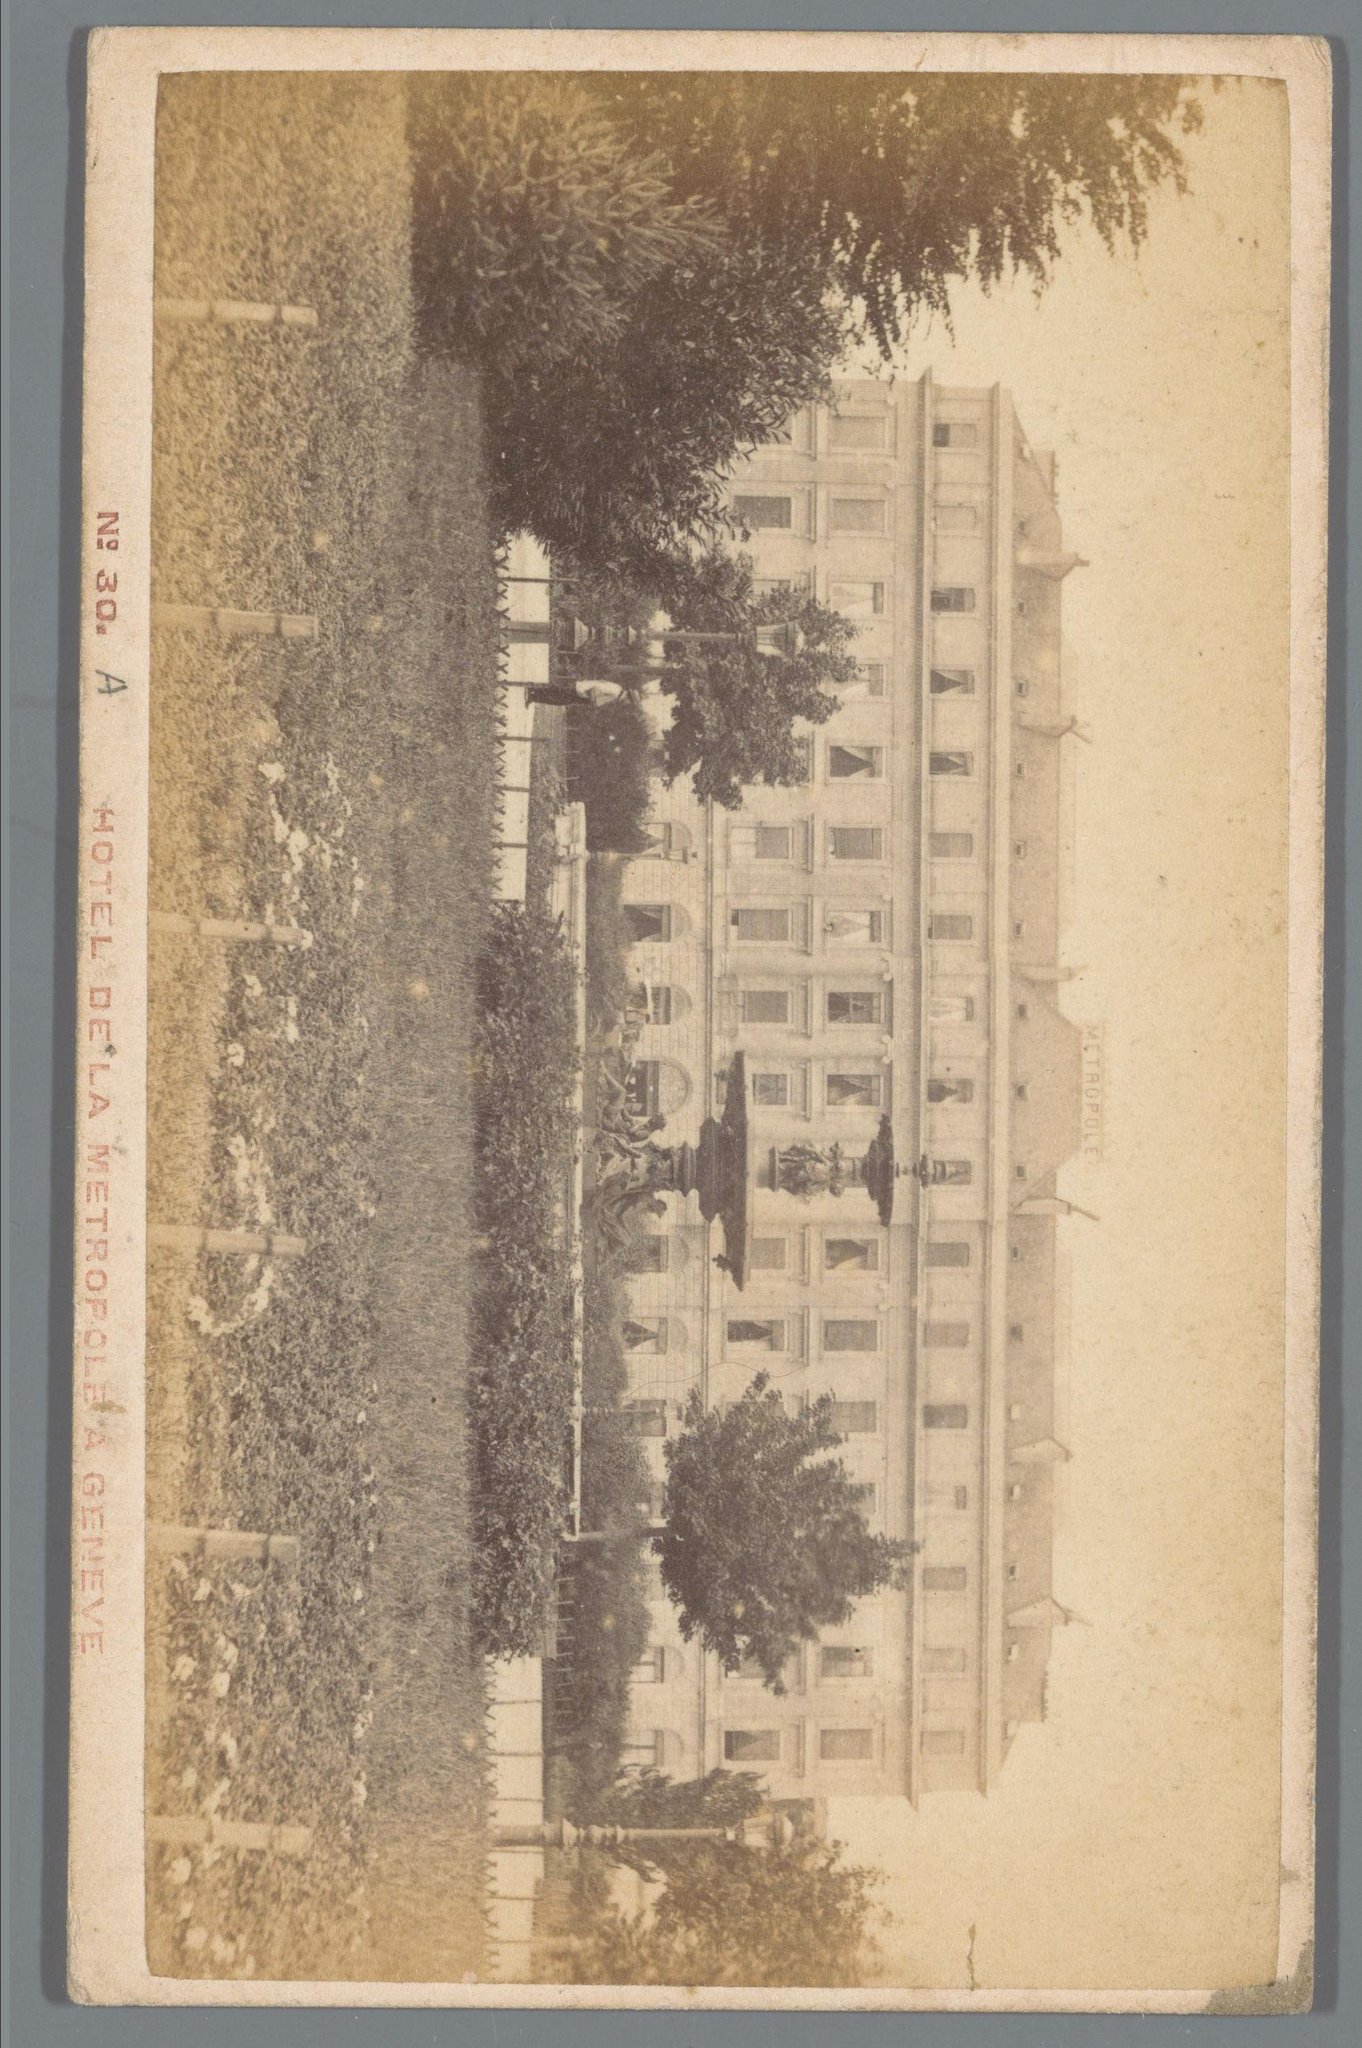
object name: carte de visite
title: Hôtel de la Métropole, Genève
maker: auguste garcin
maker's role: fotograaf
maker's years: 1816-1895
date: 1853-1895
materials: cardboard, paper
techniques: albumen print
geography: geneva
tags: ornamental fountain, hotel, hostelry, inn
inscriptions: inscription: ‘Suisse Savoie/ Garcin/ Photographe/ a/ Geneve/ Midi de la France’, inscription: ‘A’, number: ‘No 30.’